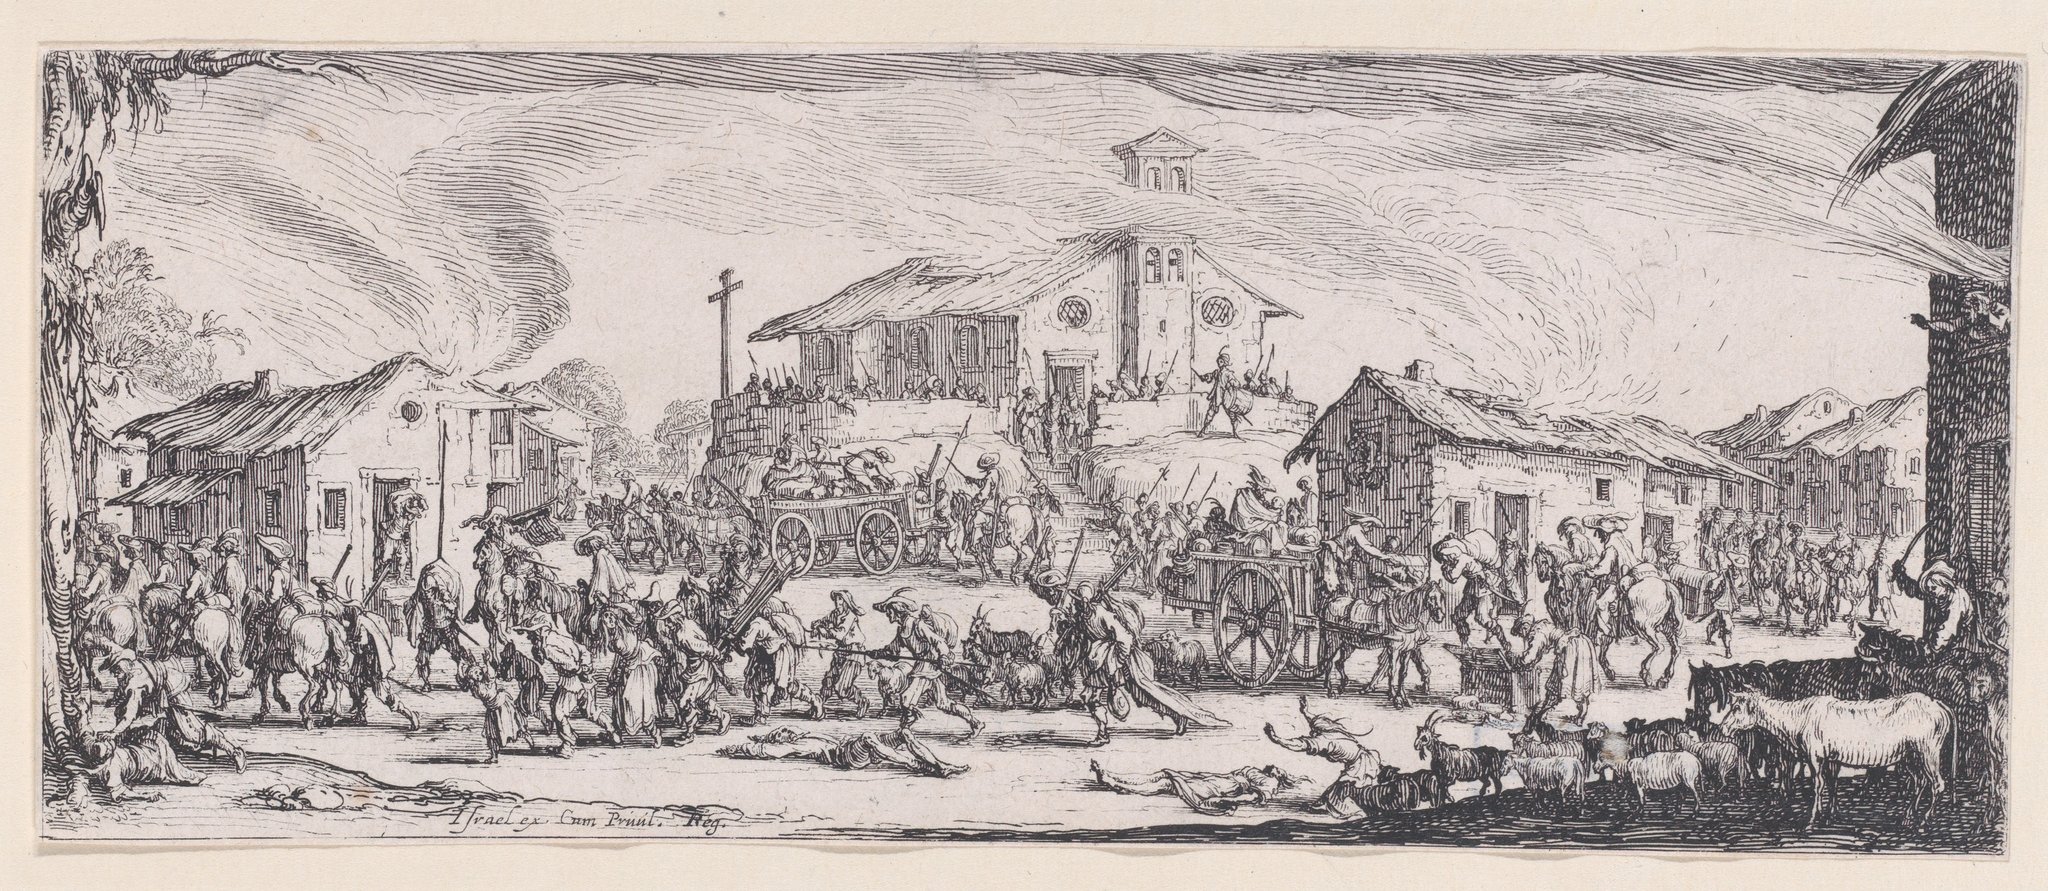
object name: print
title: Pillage et Incendie d'un Village (Looting and Burning of a Village), plate 7 from "Les Misères et les Mal-Heures de la Guerre" (The Miseries and Misfortunes of War)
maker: jacques callot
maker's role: artist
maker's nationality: french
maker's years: 1592-1635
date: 1633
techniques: etching